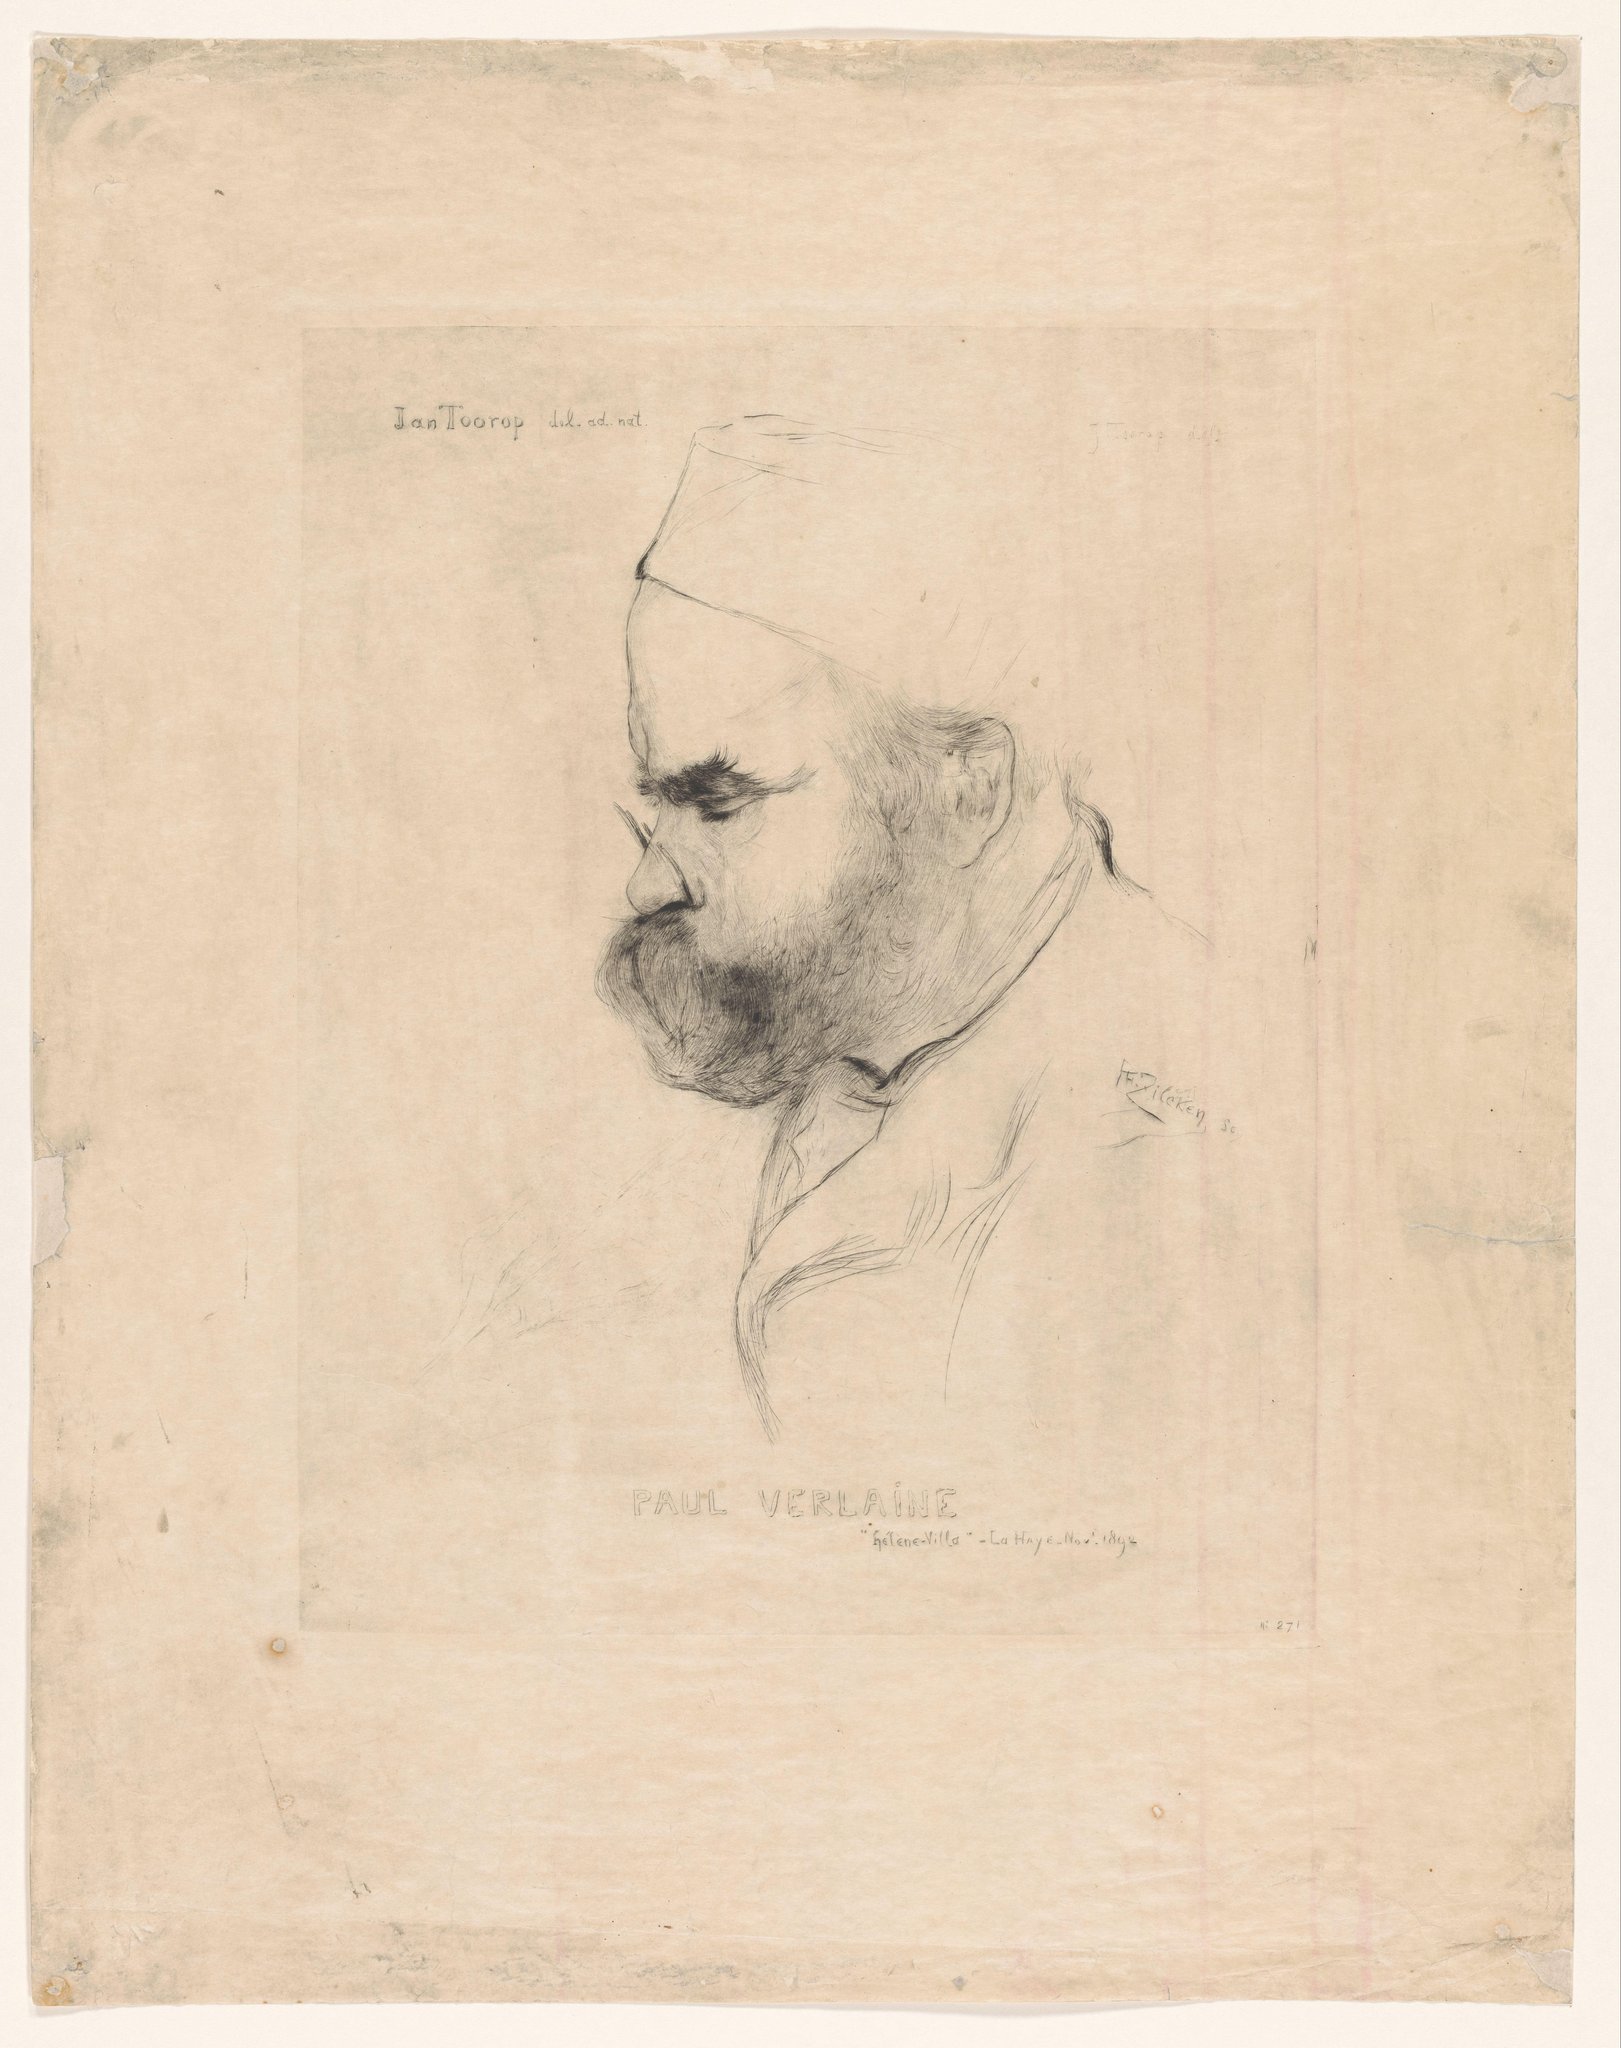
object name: print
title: Paul Verlaine 'Hélene-Villa' - La Haye - Nov 1892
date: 1811-1892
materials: paper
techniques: drypoint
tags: paris, paul verlaine, portrait of a writer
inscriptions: collector's mark: Lugt 2760, collector's mark: Lugt 2228, annotation: ‘1/4/86 / 8+3 [in getekende driehoek]’